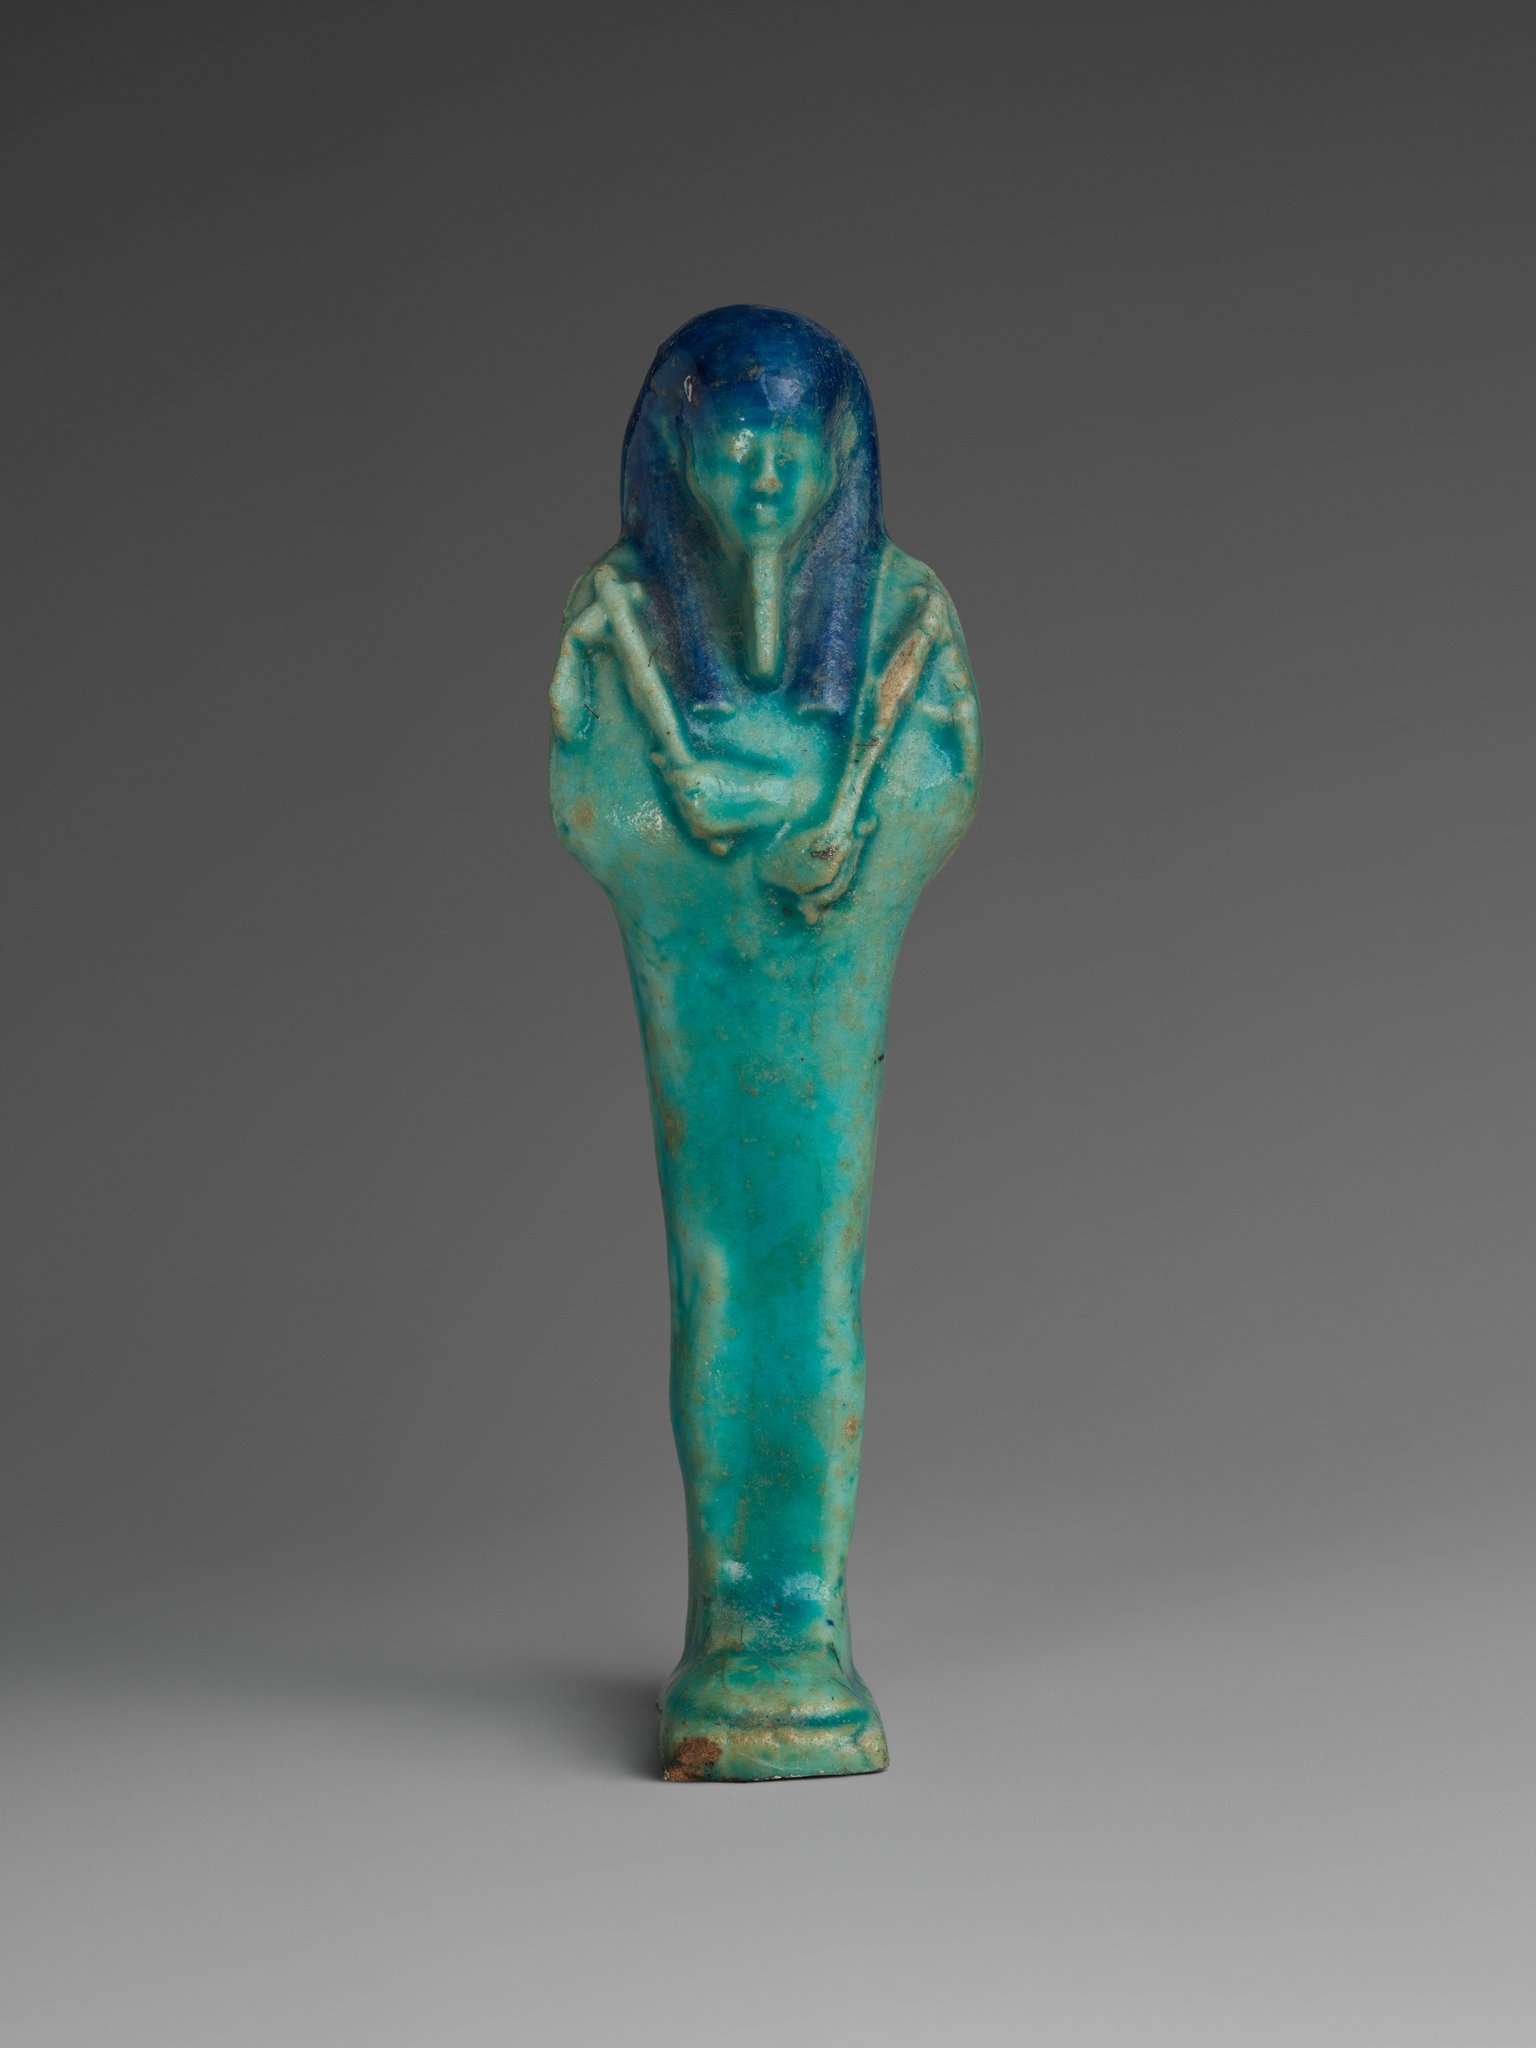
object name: shabti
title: Uninscribed shabti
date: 400-250 BCE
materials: faience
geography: egypt